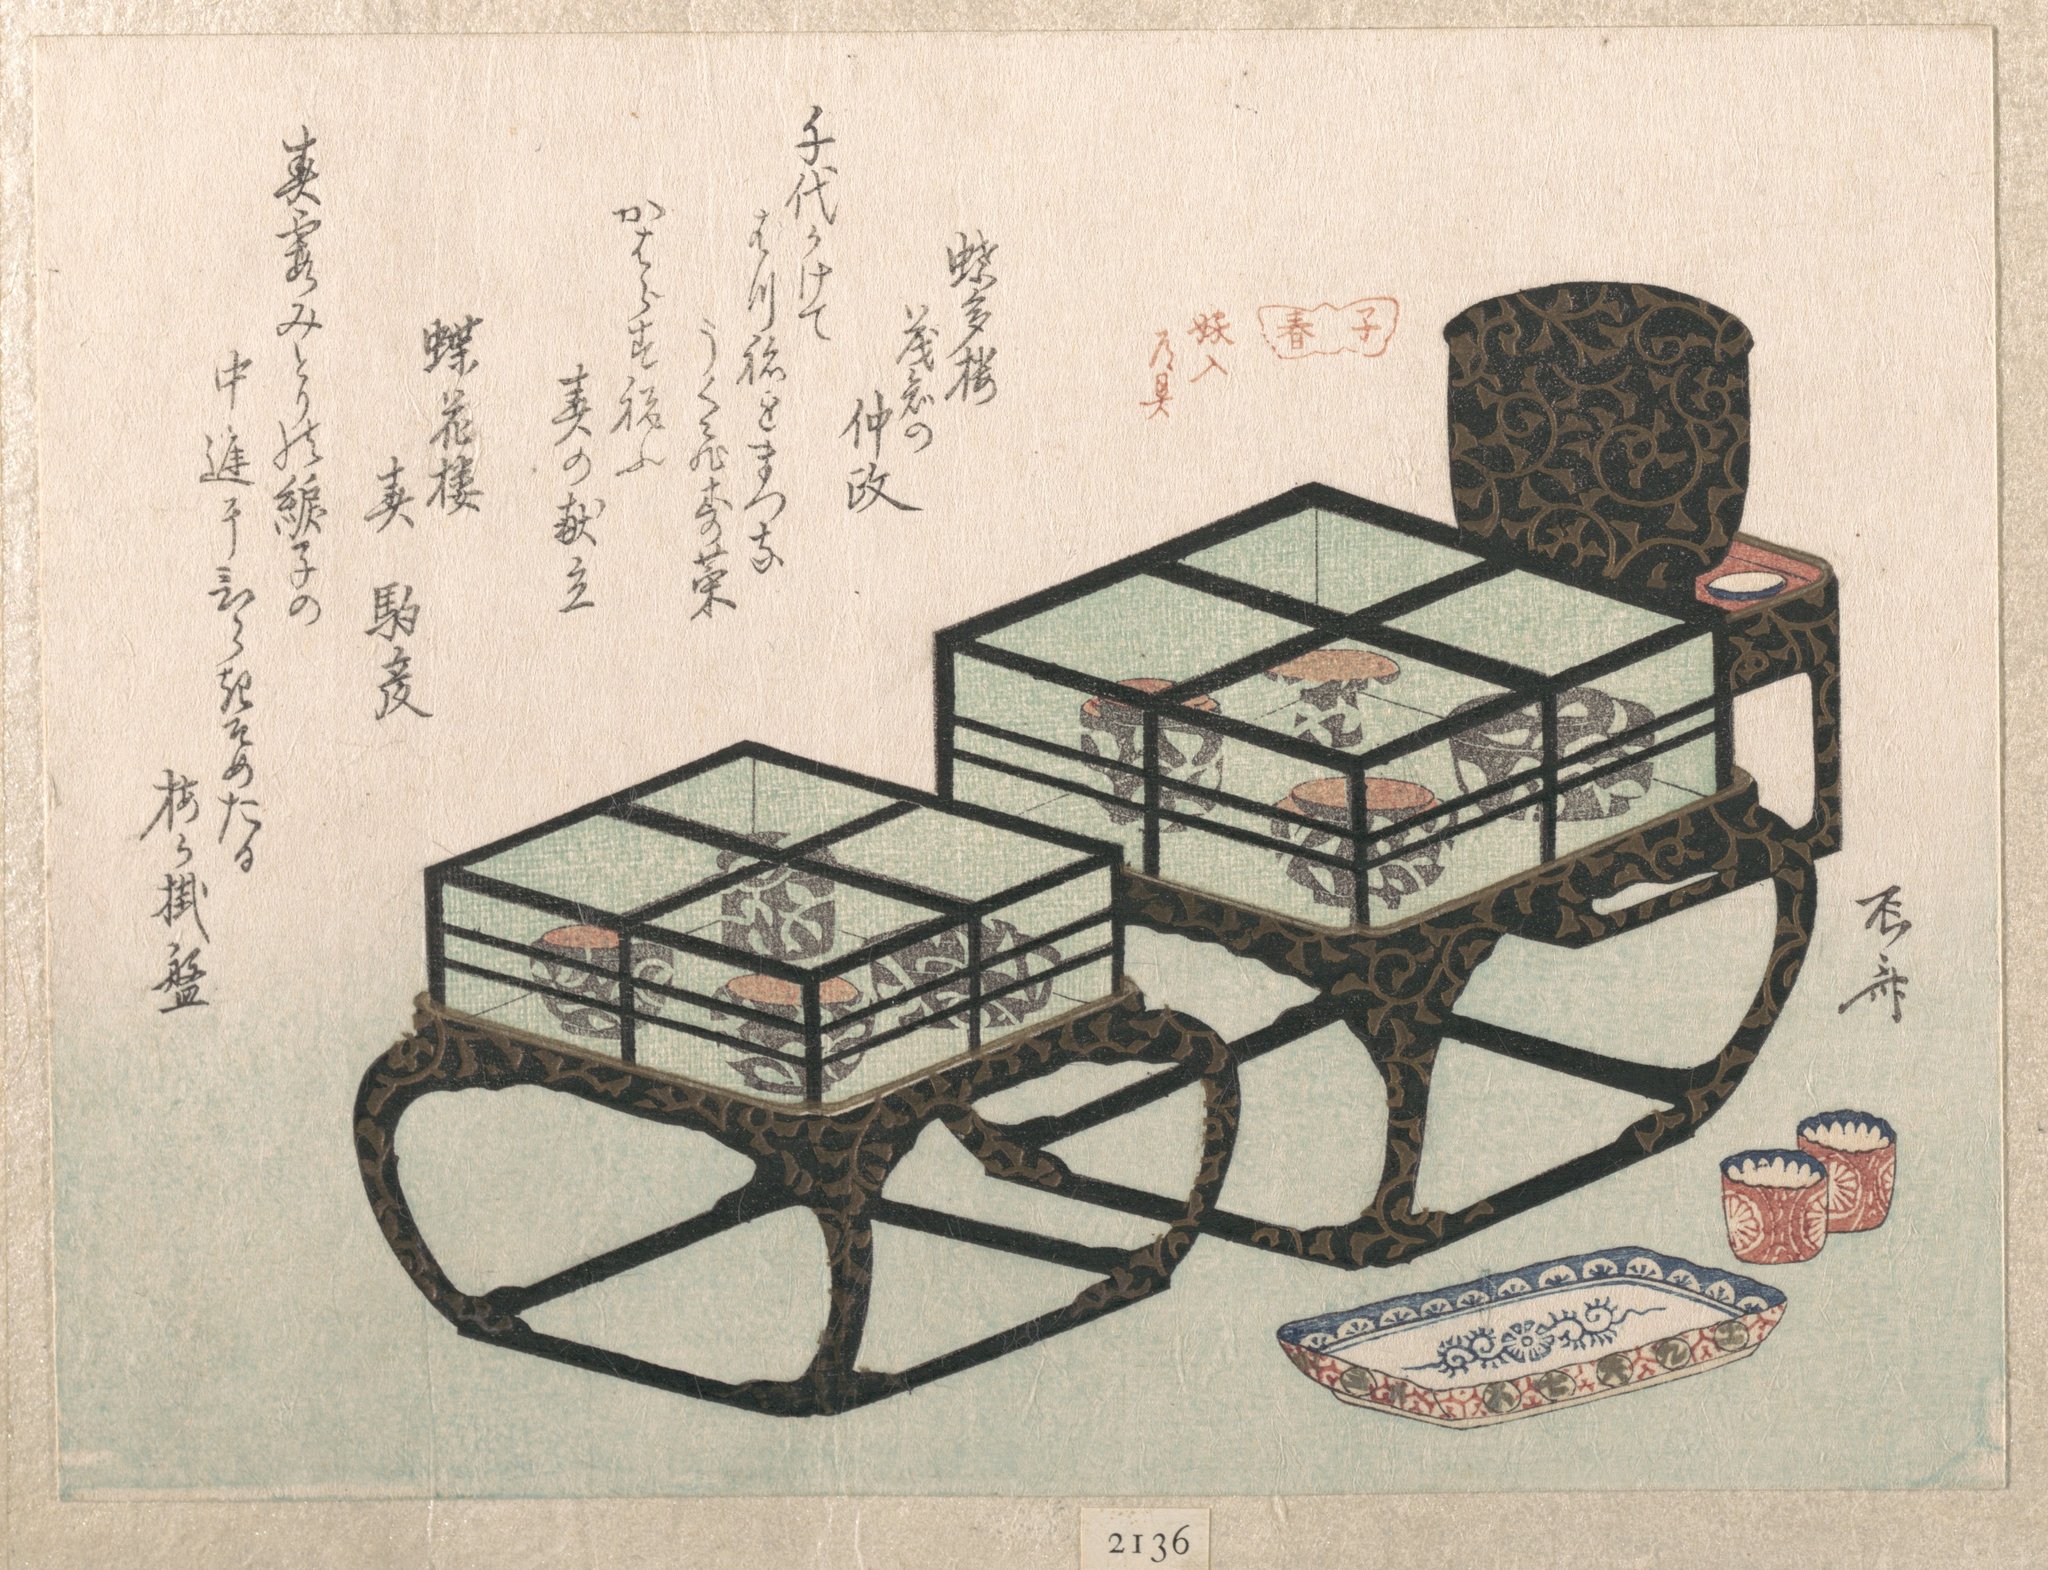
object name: print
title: Small Dinner Tables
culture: japanese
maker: ryūryūkyo shinsai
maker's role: artist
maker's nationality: japanese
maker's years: 1799-1823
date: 1816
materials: ink, paper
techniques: surimono, woodblock print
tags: tables